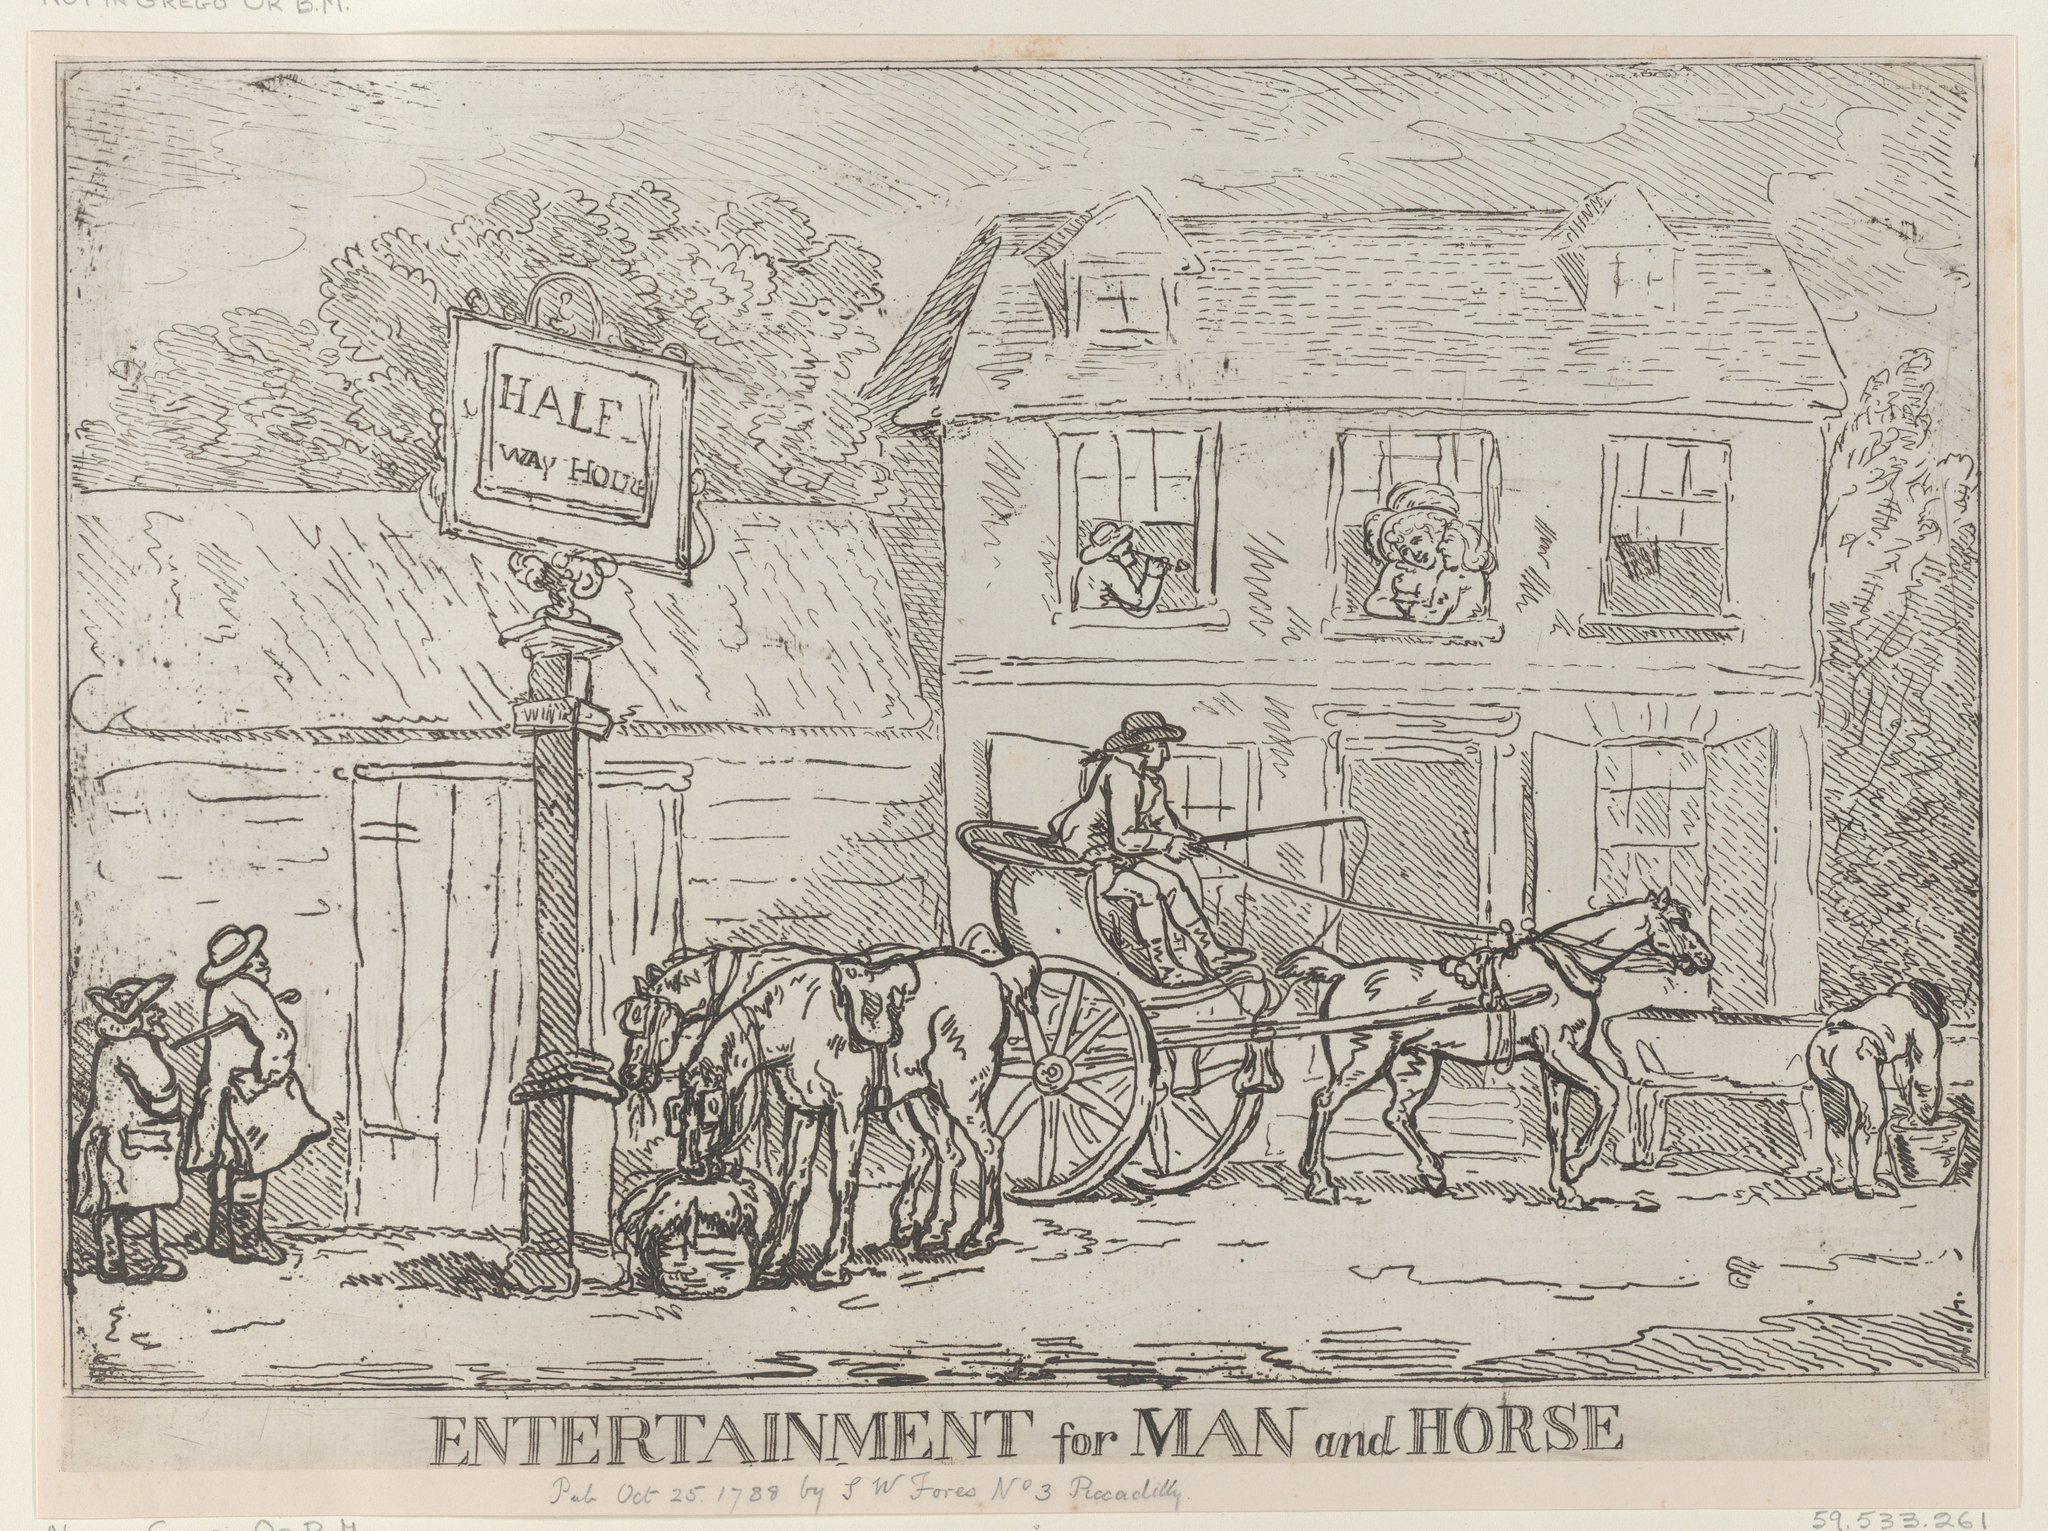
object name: print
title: Entertainment for Man and Horse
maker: thomas rowlandson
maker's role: artist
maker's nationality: british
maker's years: 1757-1827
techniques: etching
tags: houses,horses,carriages